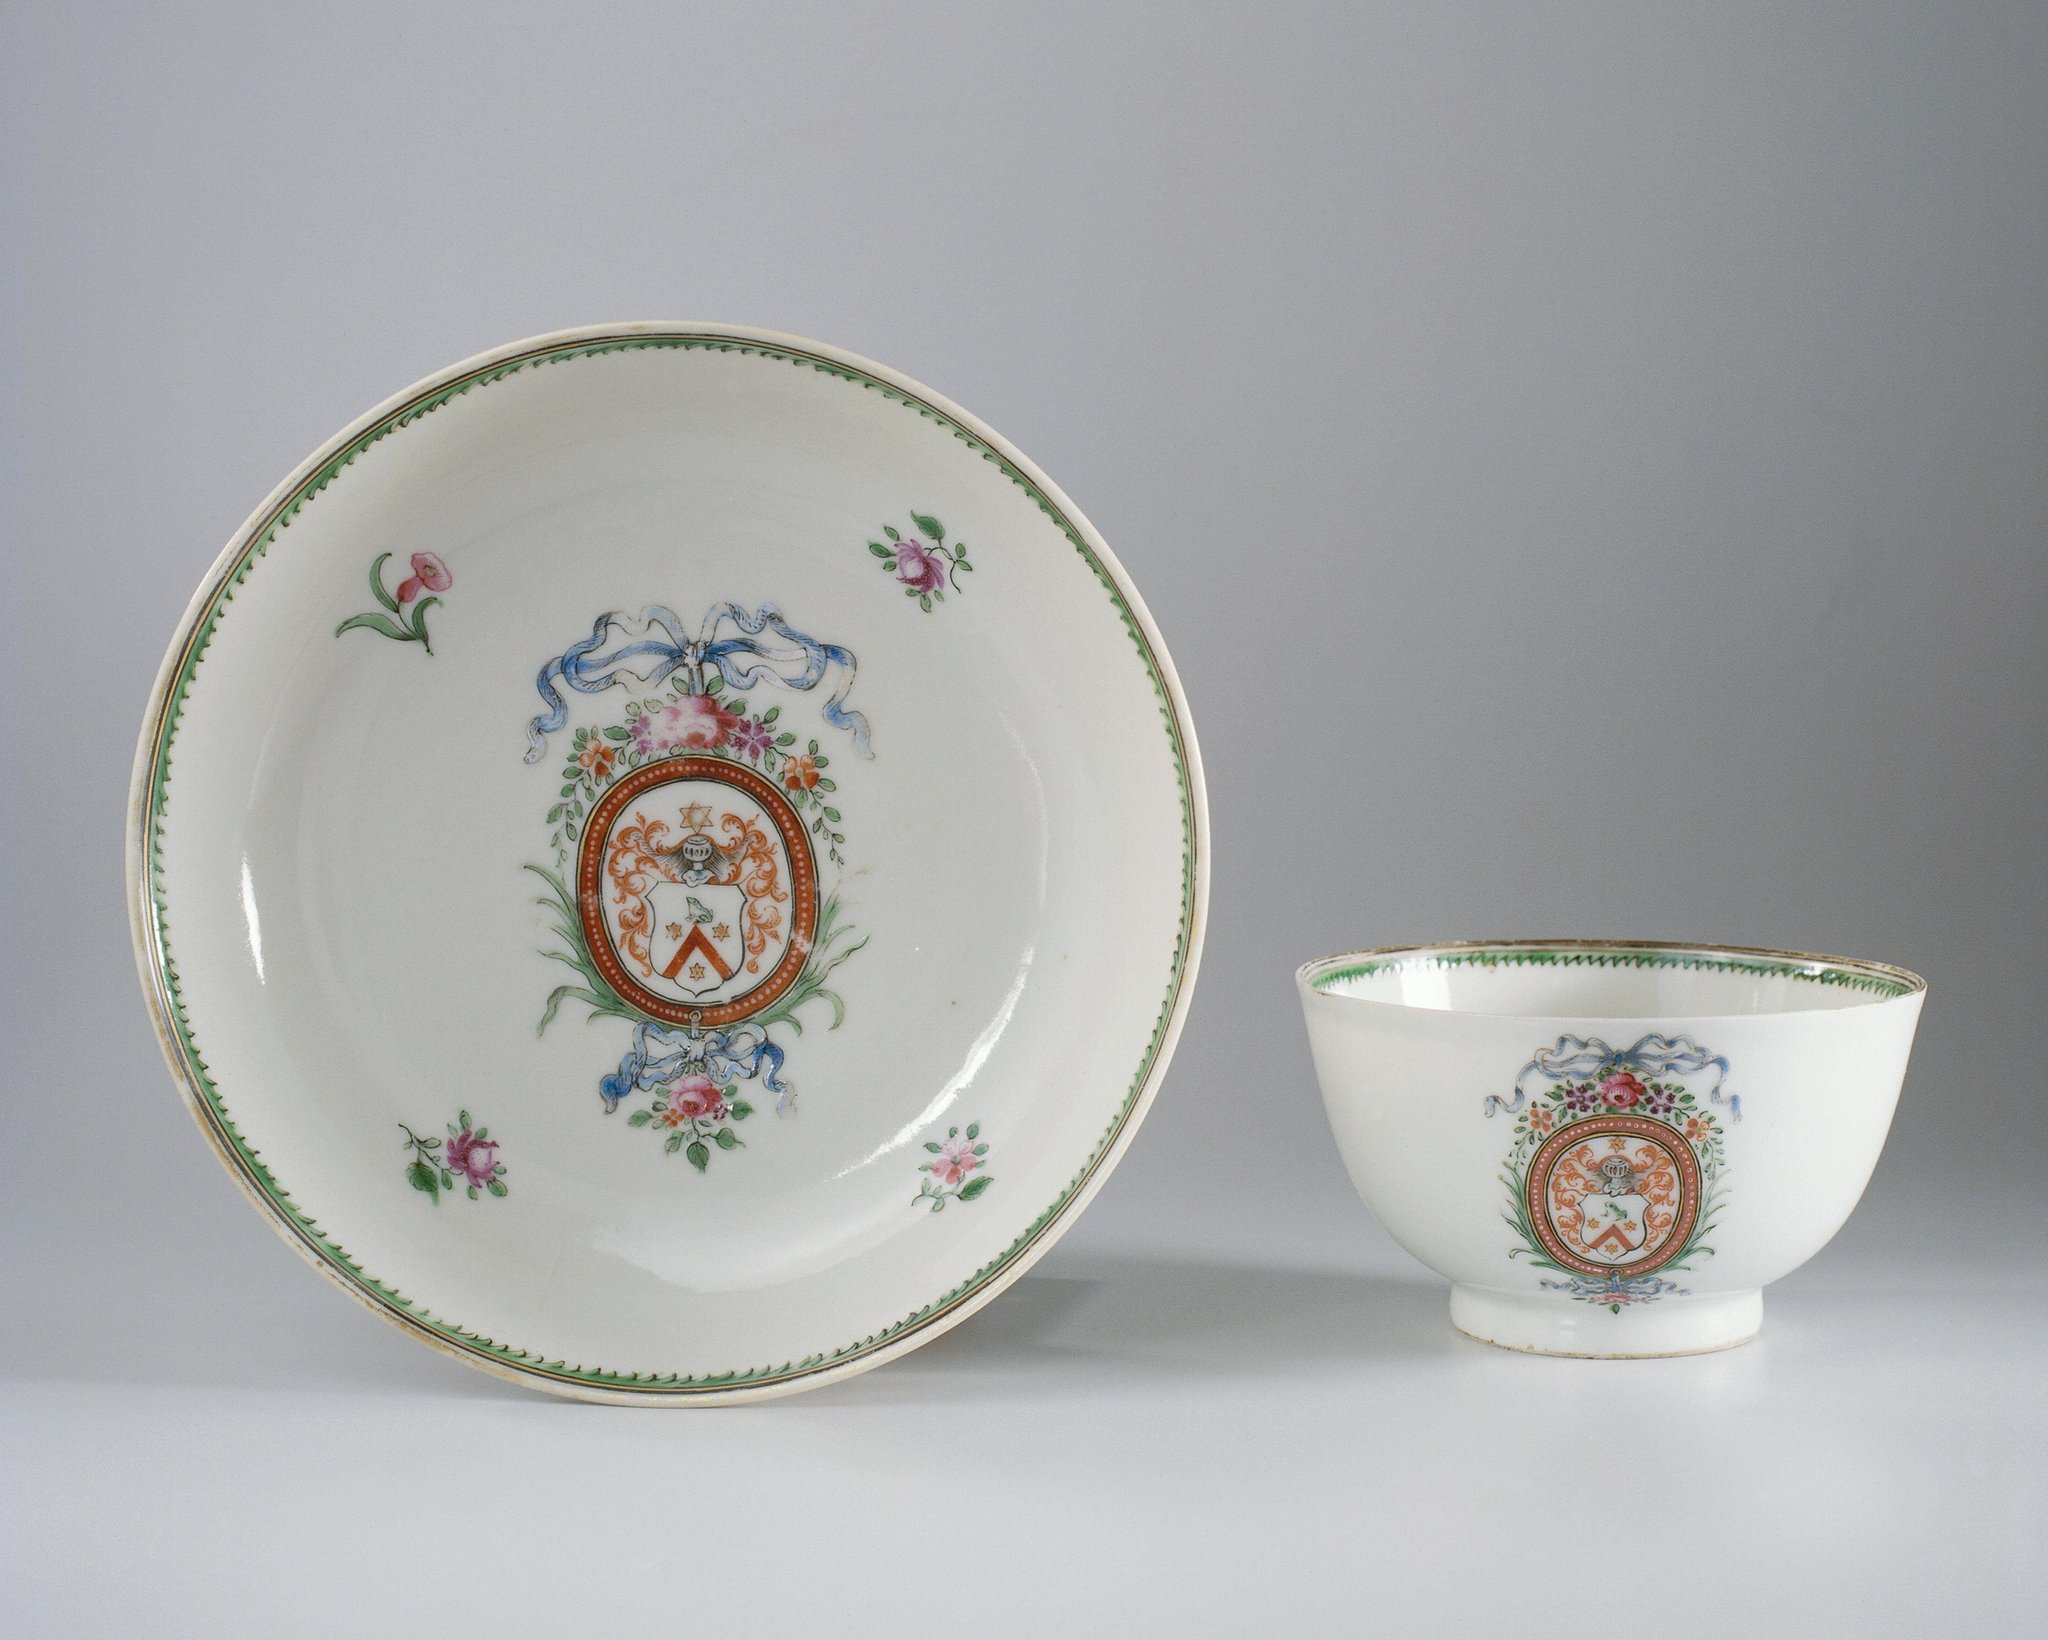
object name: cup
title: Cup with the arms of the Kikkert family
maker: Anonymous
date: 1777-1778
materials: glaze, gold, paint, porcelain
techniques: firing, gilding, turning, vitrification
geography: china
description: In het centrum van de schotel en op de buitenzijde van de kop in een medaillon het wapen van de familie Kikkert. Het wapen heeft een rode keper met boven een kikker en twee sterren en onder een ster. Het helmteken is een ster en het dekkleed bestaat uit bladranken in ijzerrood. Het medaillon is versierd met strooibloemen, blauwe linten en twee groene palmtakken. Hieromheen zijn vier bloemtakken afgebeeld. Op de rand in de binnenzijde van zowel de kop als de schotel is een band in groen en goud.